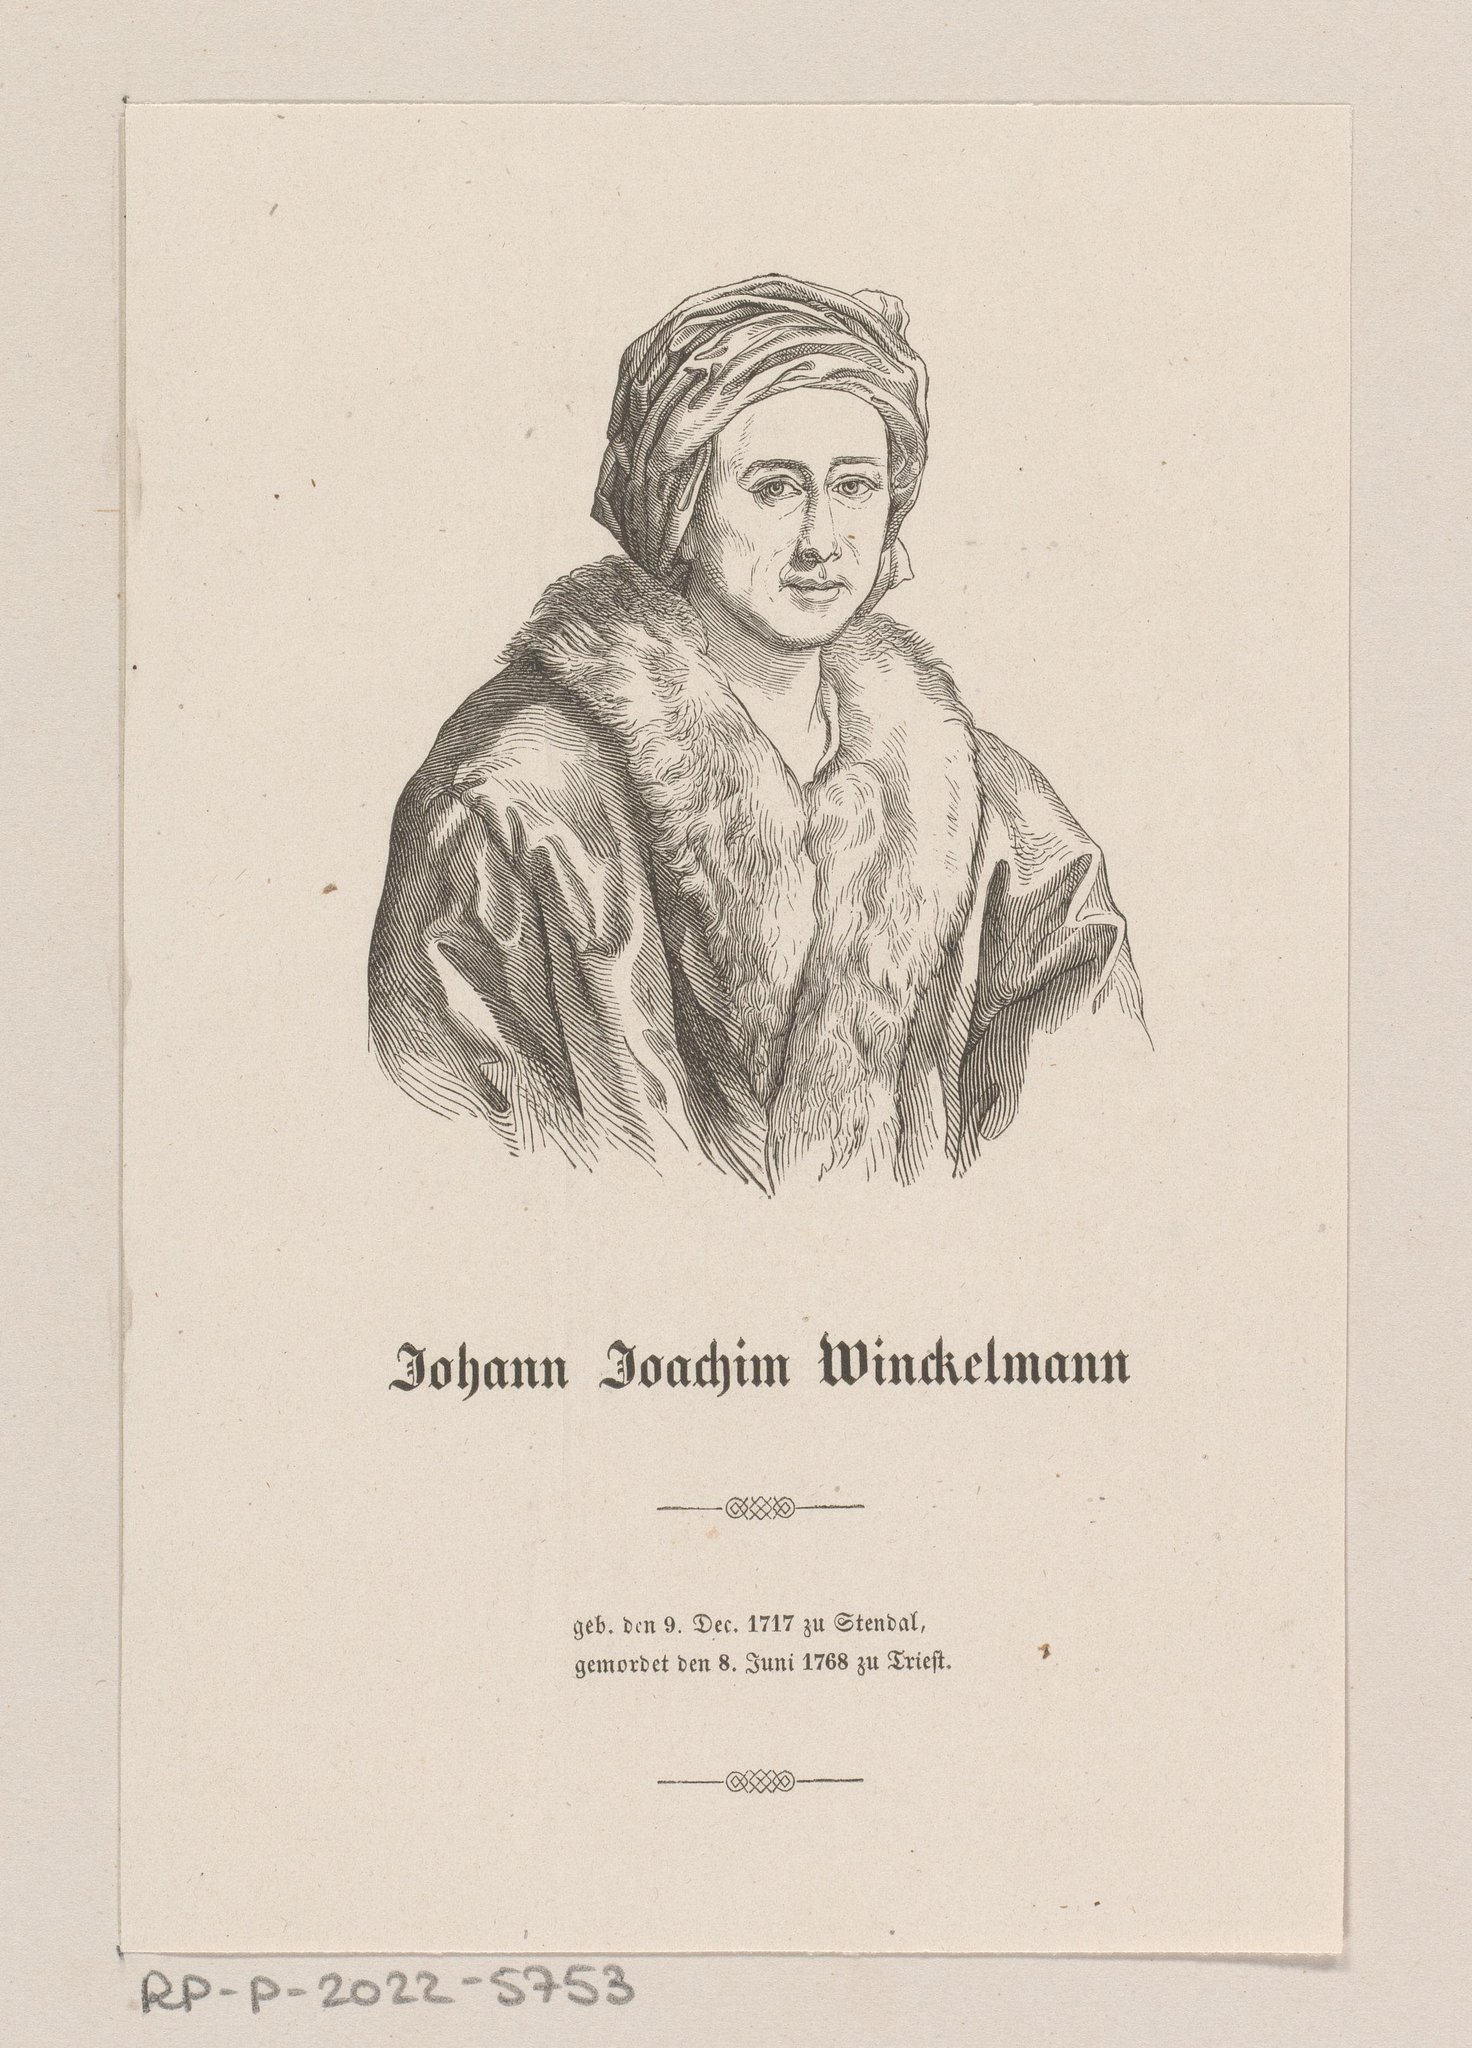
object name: print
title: Portret van Johann Joachim Winckelmann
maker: Anonymous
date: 1850-1899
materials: paper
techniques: engraving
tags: history and archaeology (+ portrait of scholar, scientist), historical persons